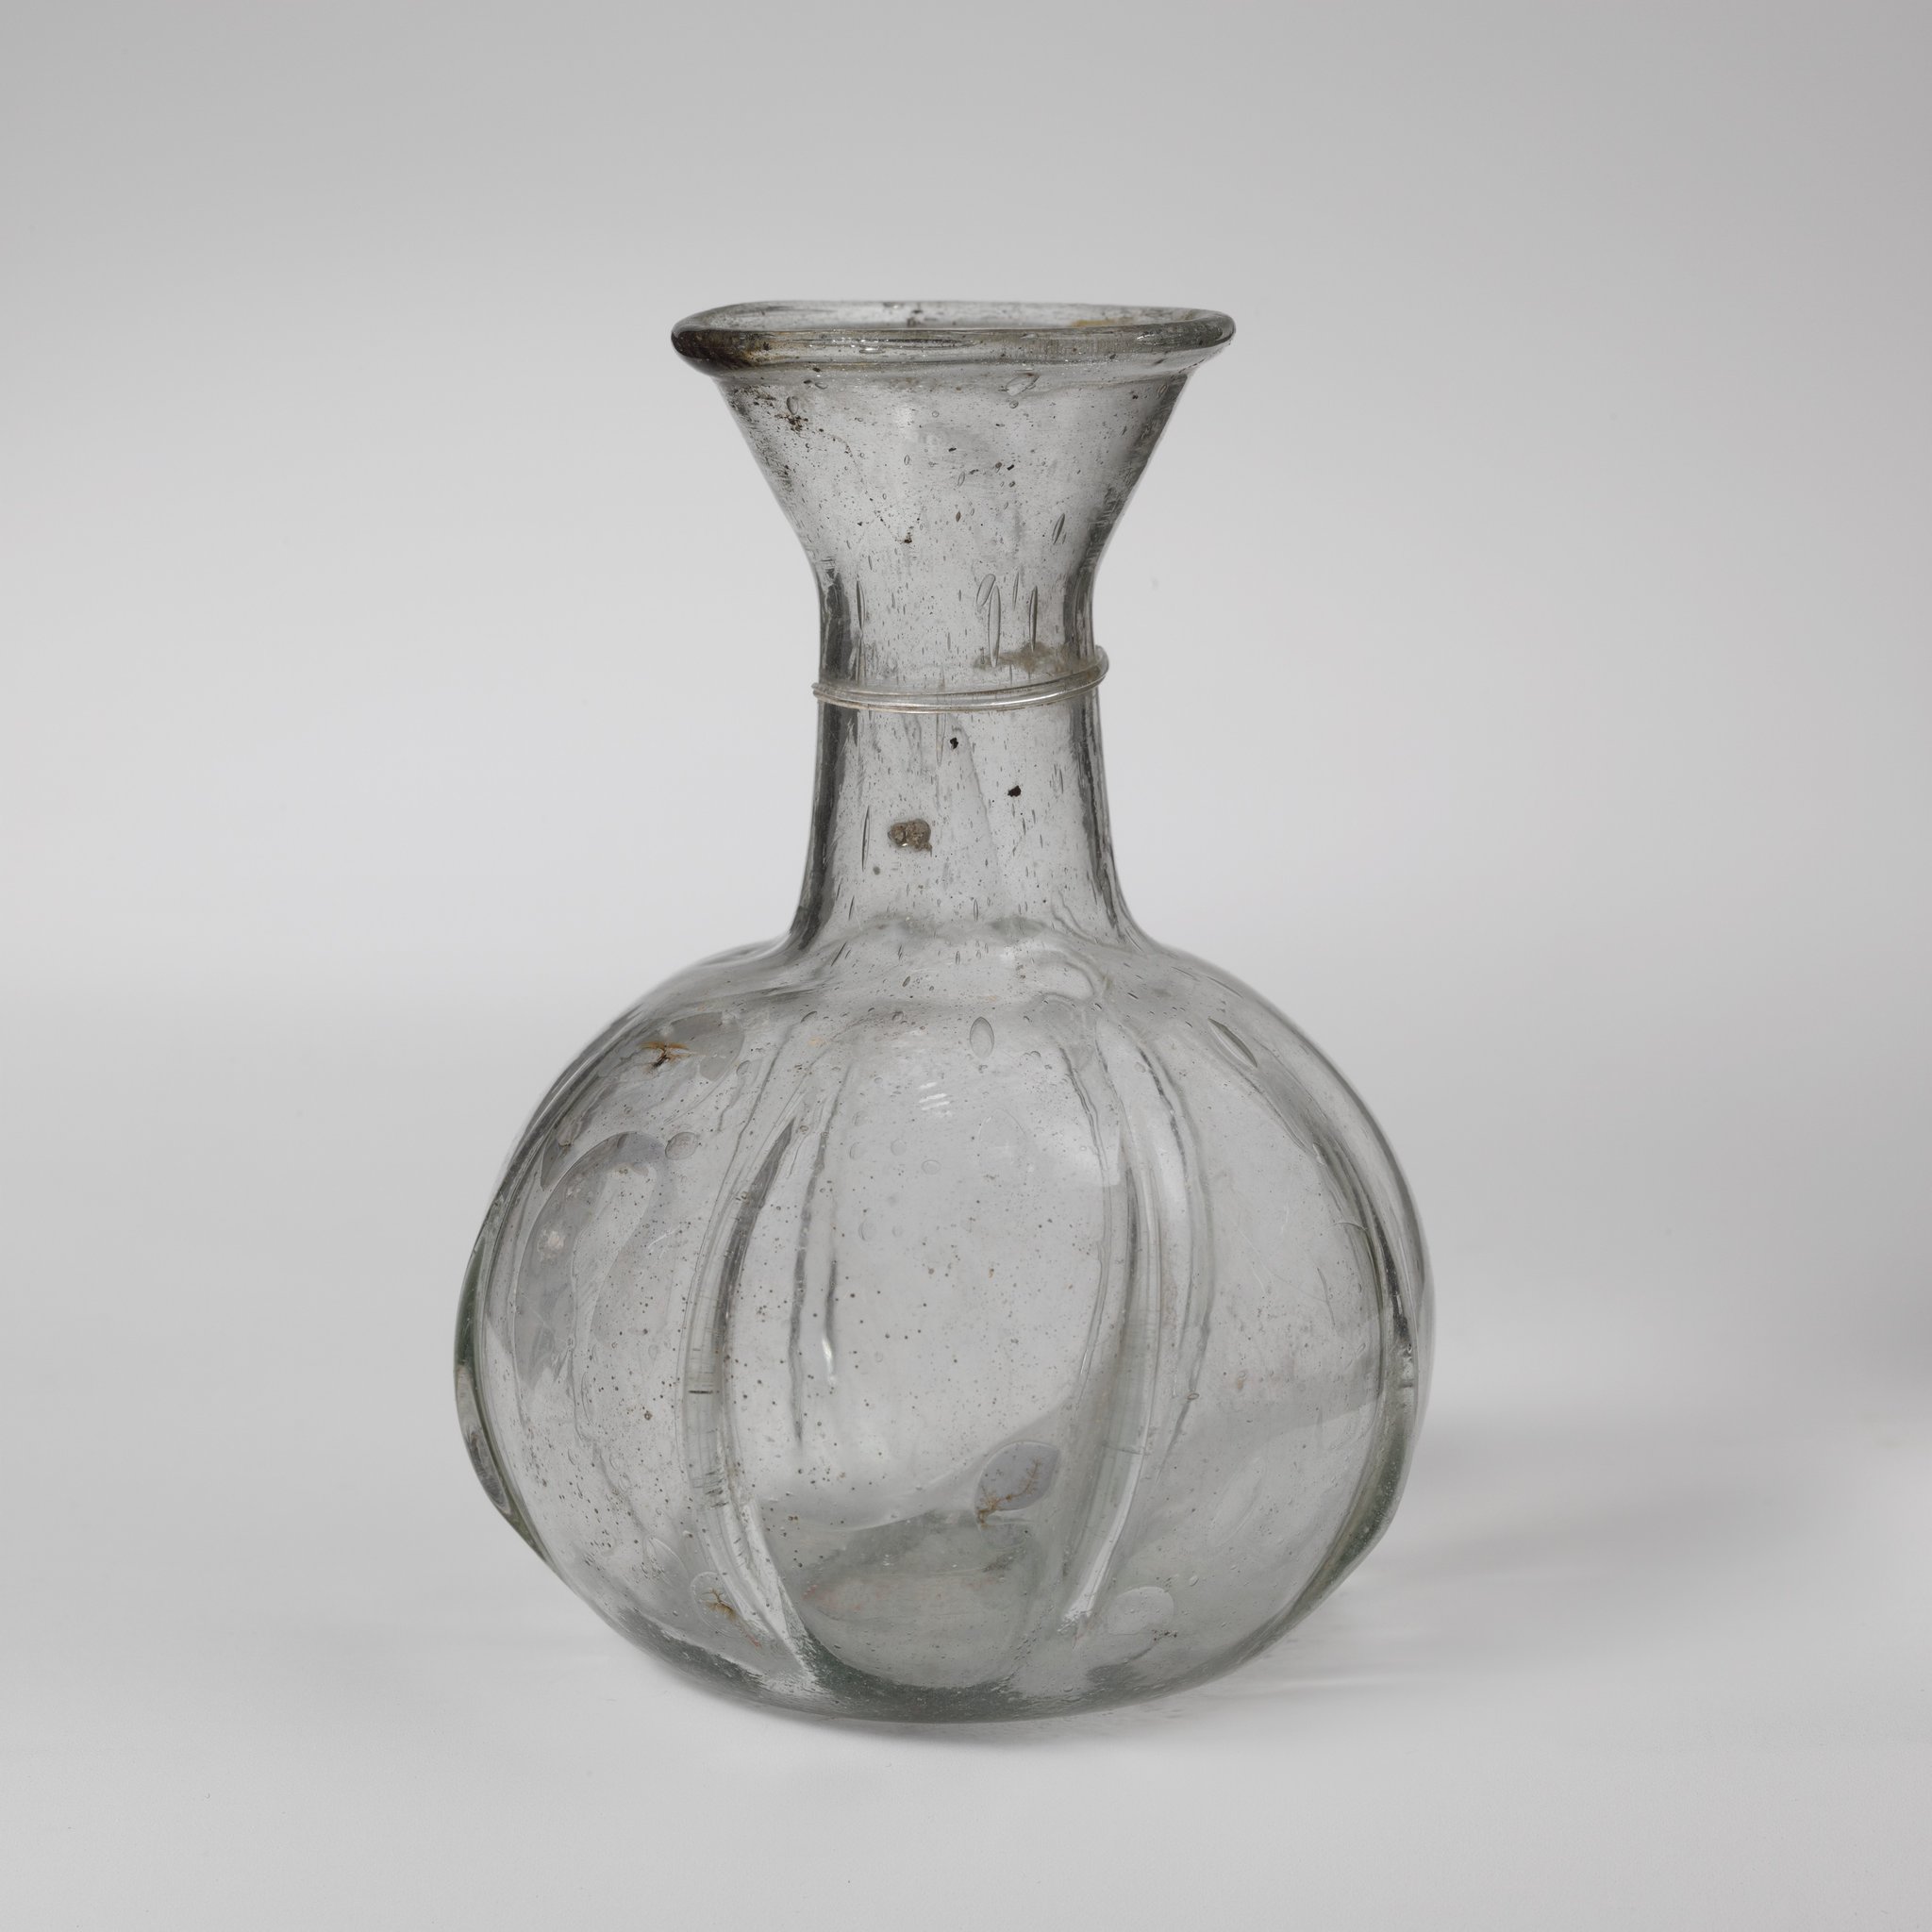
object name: flask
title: Glass flask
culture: roman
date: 201-400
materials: glass